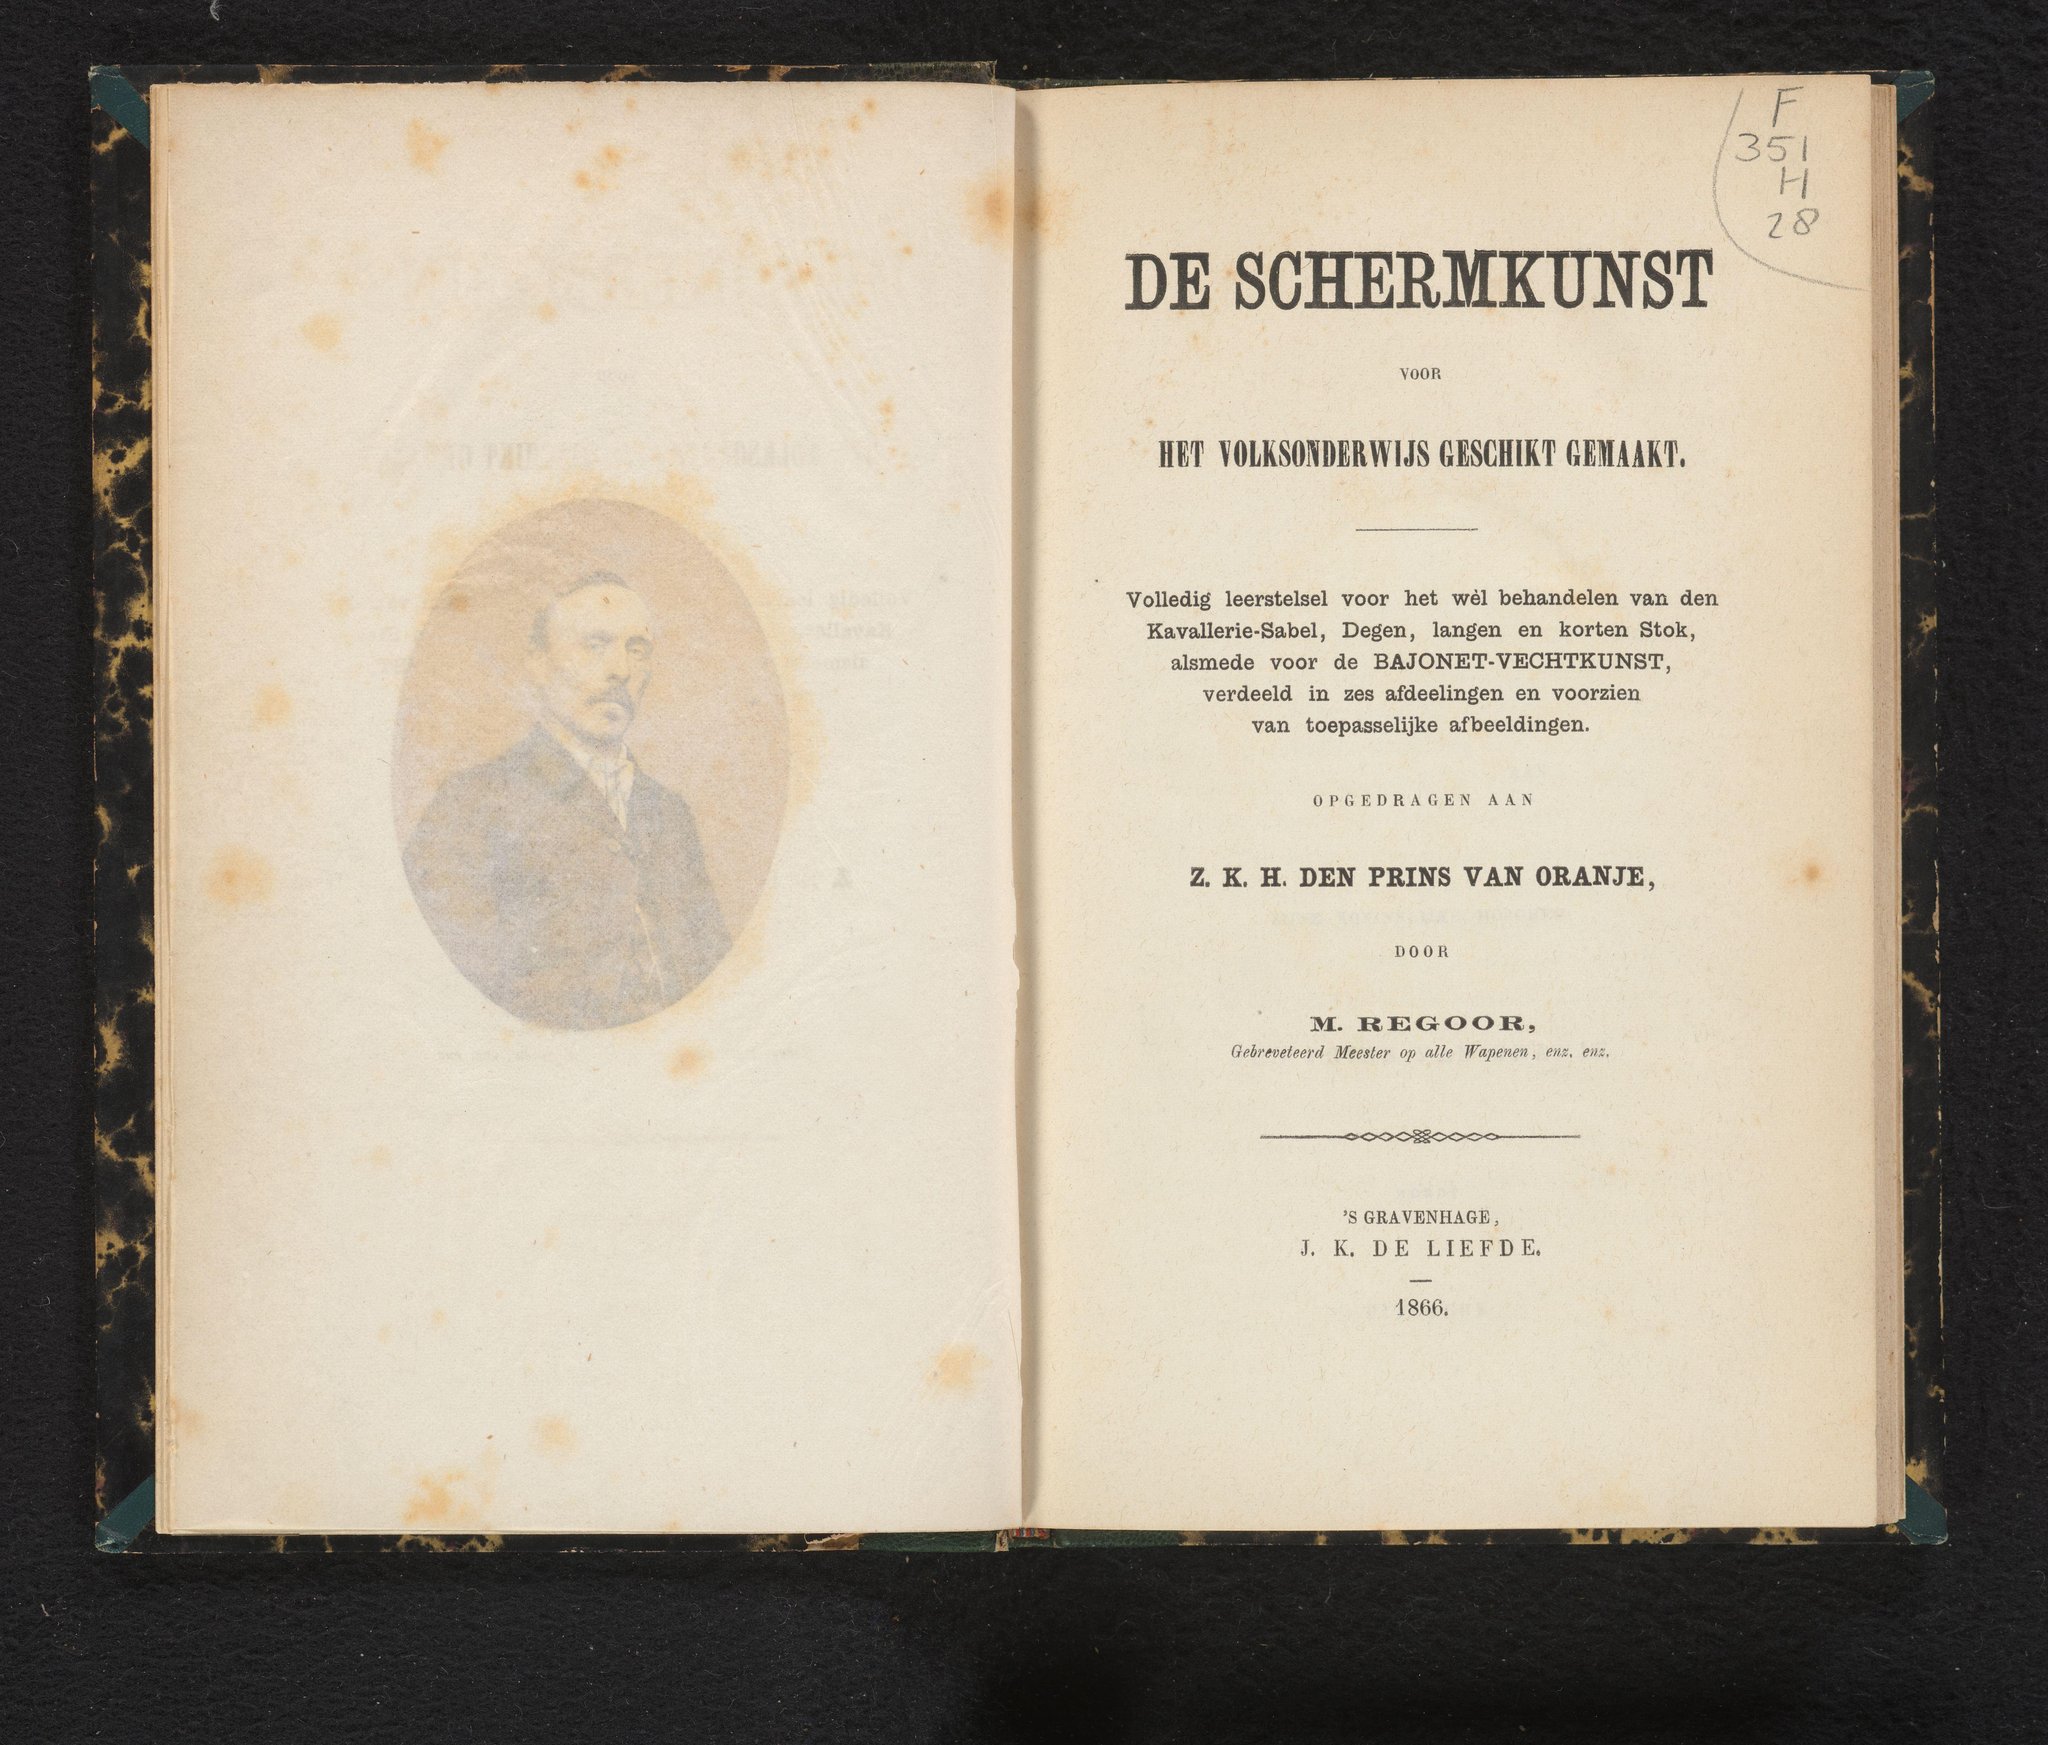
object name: book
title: De schermkunst voor het volksonderwijs geschikt gemaakt : volledig leerstelsel voor het wèl behandelen van den kavallerie-sabel, degen, langen en korten stok, alsmede voor de bajonet-vechtkunst, verdeeld in zes afdeelingen en voorzien van toepasselijke abeeldingen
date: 1866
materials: cardboard, paper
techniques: albumen print, lithograph, printing, marbling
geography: the hague